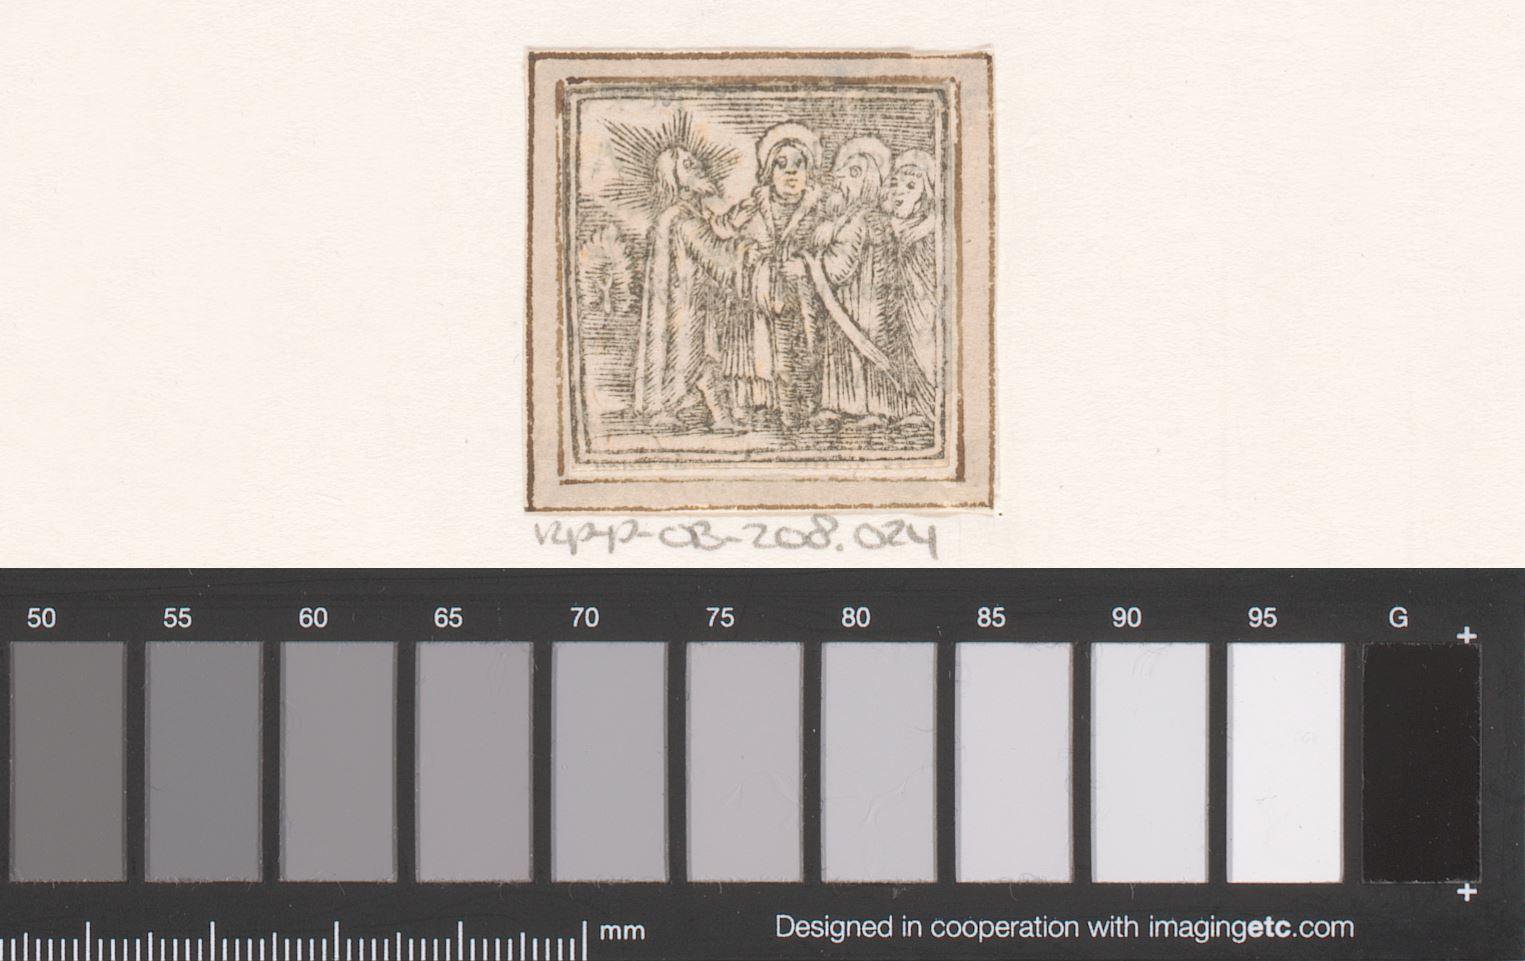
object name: print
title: Christus instrueert zijn discipelen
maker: Anonymous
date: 1600-1699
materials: paper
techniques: woodcut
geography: netherlands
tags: christ explaining his doctrine to the apostles and disciples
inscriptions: collector's mark: Lugt 2228